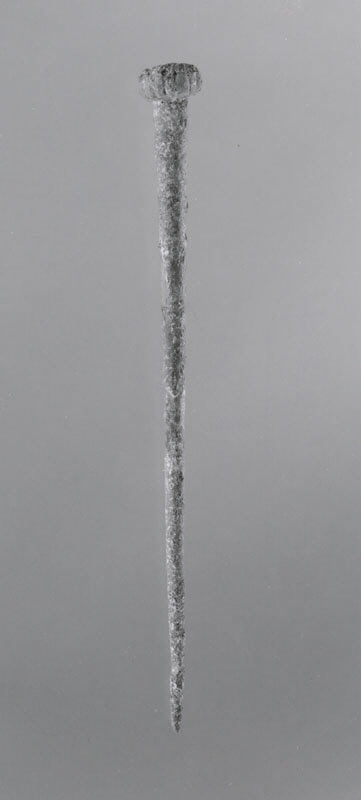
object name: pin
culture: bactria-margiana archaeological complex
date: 2333-1668 BCE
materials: copper alloy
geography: bactria-margiana